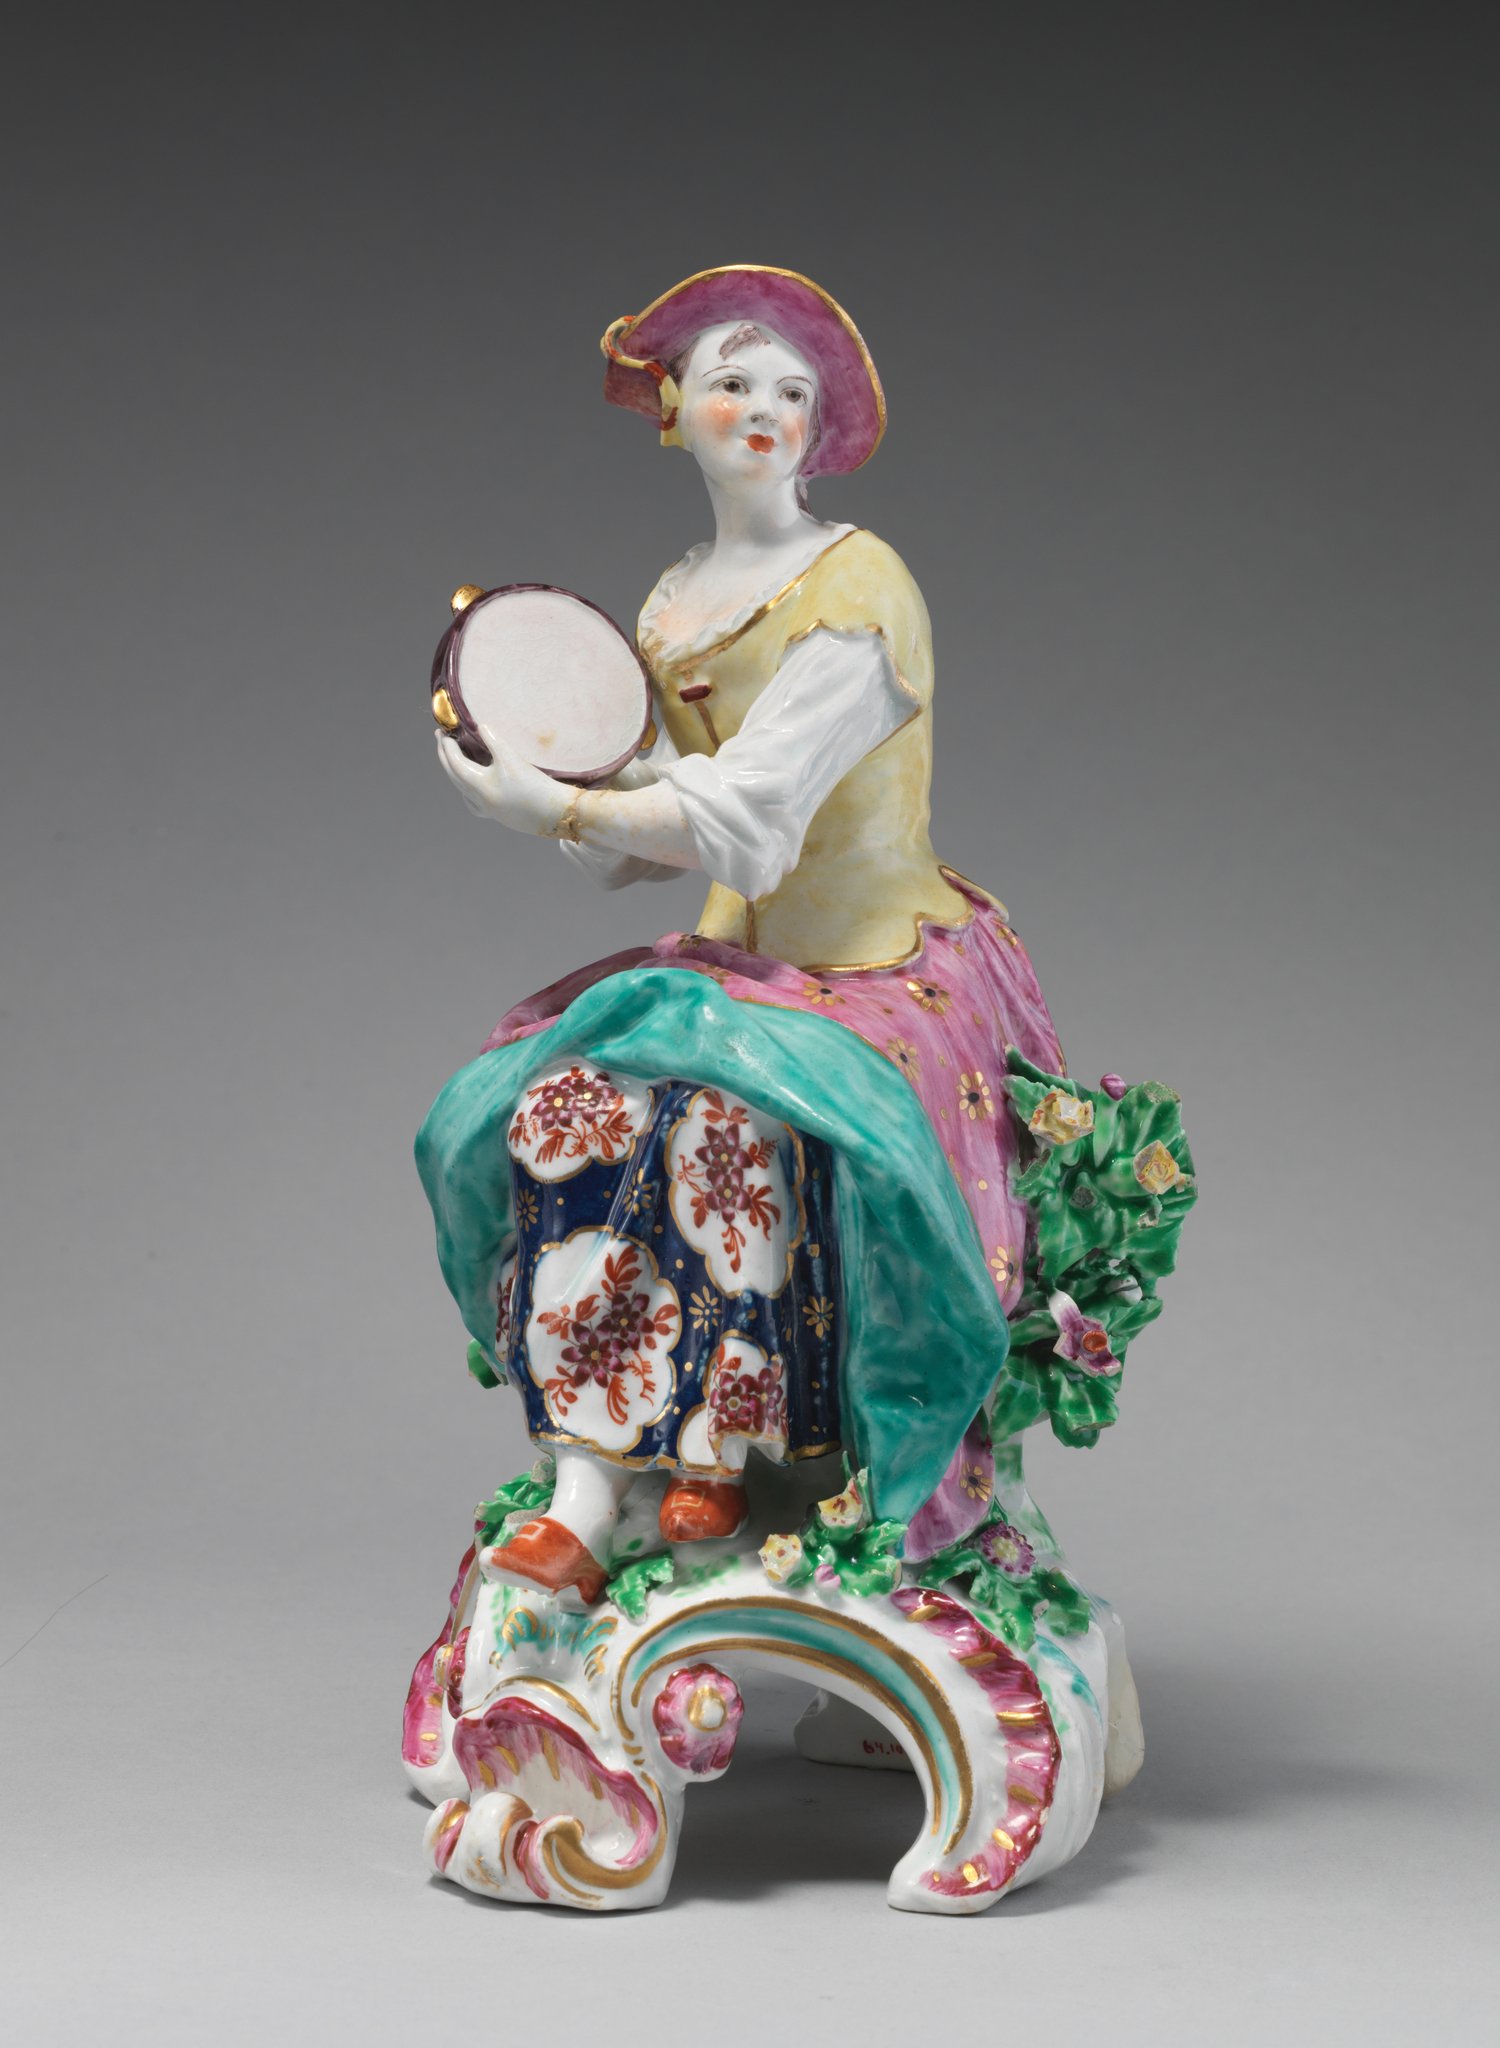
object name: figure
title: Seated musician (one of a pair)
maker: bow porcelain factory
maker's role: factory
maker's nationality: british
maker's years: 1747-1776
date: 1765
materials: soft paste porcelain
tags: musical instruments,women,musicians